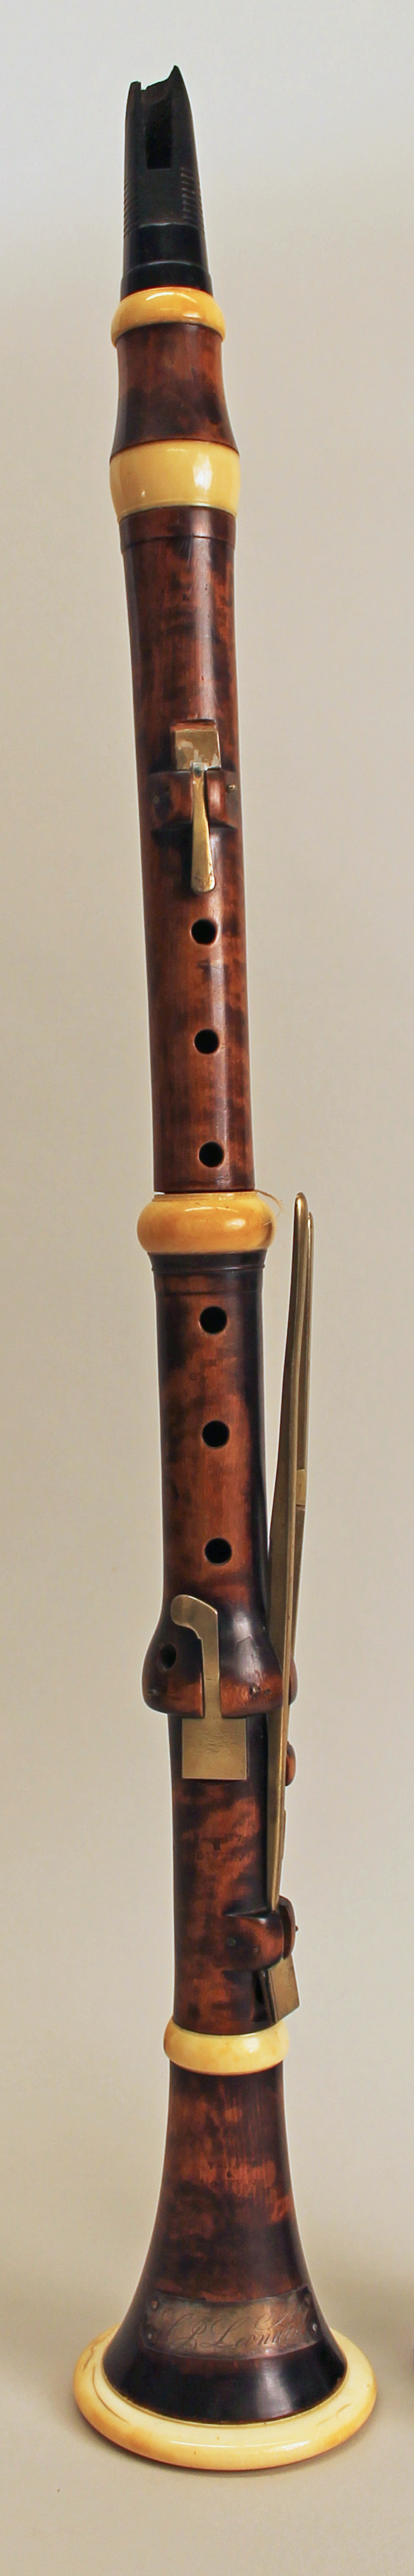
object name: clarinet in b flat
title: Clarinet in B-flat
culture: american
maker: benjamin ferris and simon giffin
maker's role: maker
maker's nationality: american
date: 1822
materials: wood, brass, ivory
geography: united states